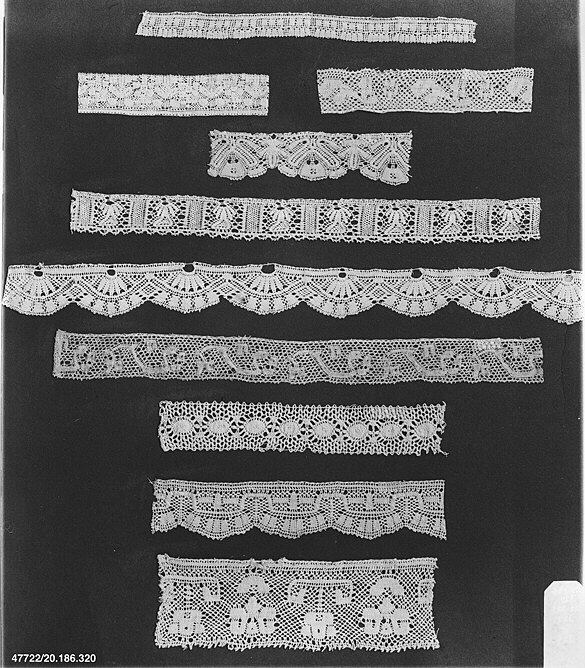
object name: edging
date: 1701-1800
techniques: lace